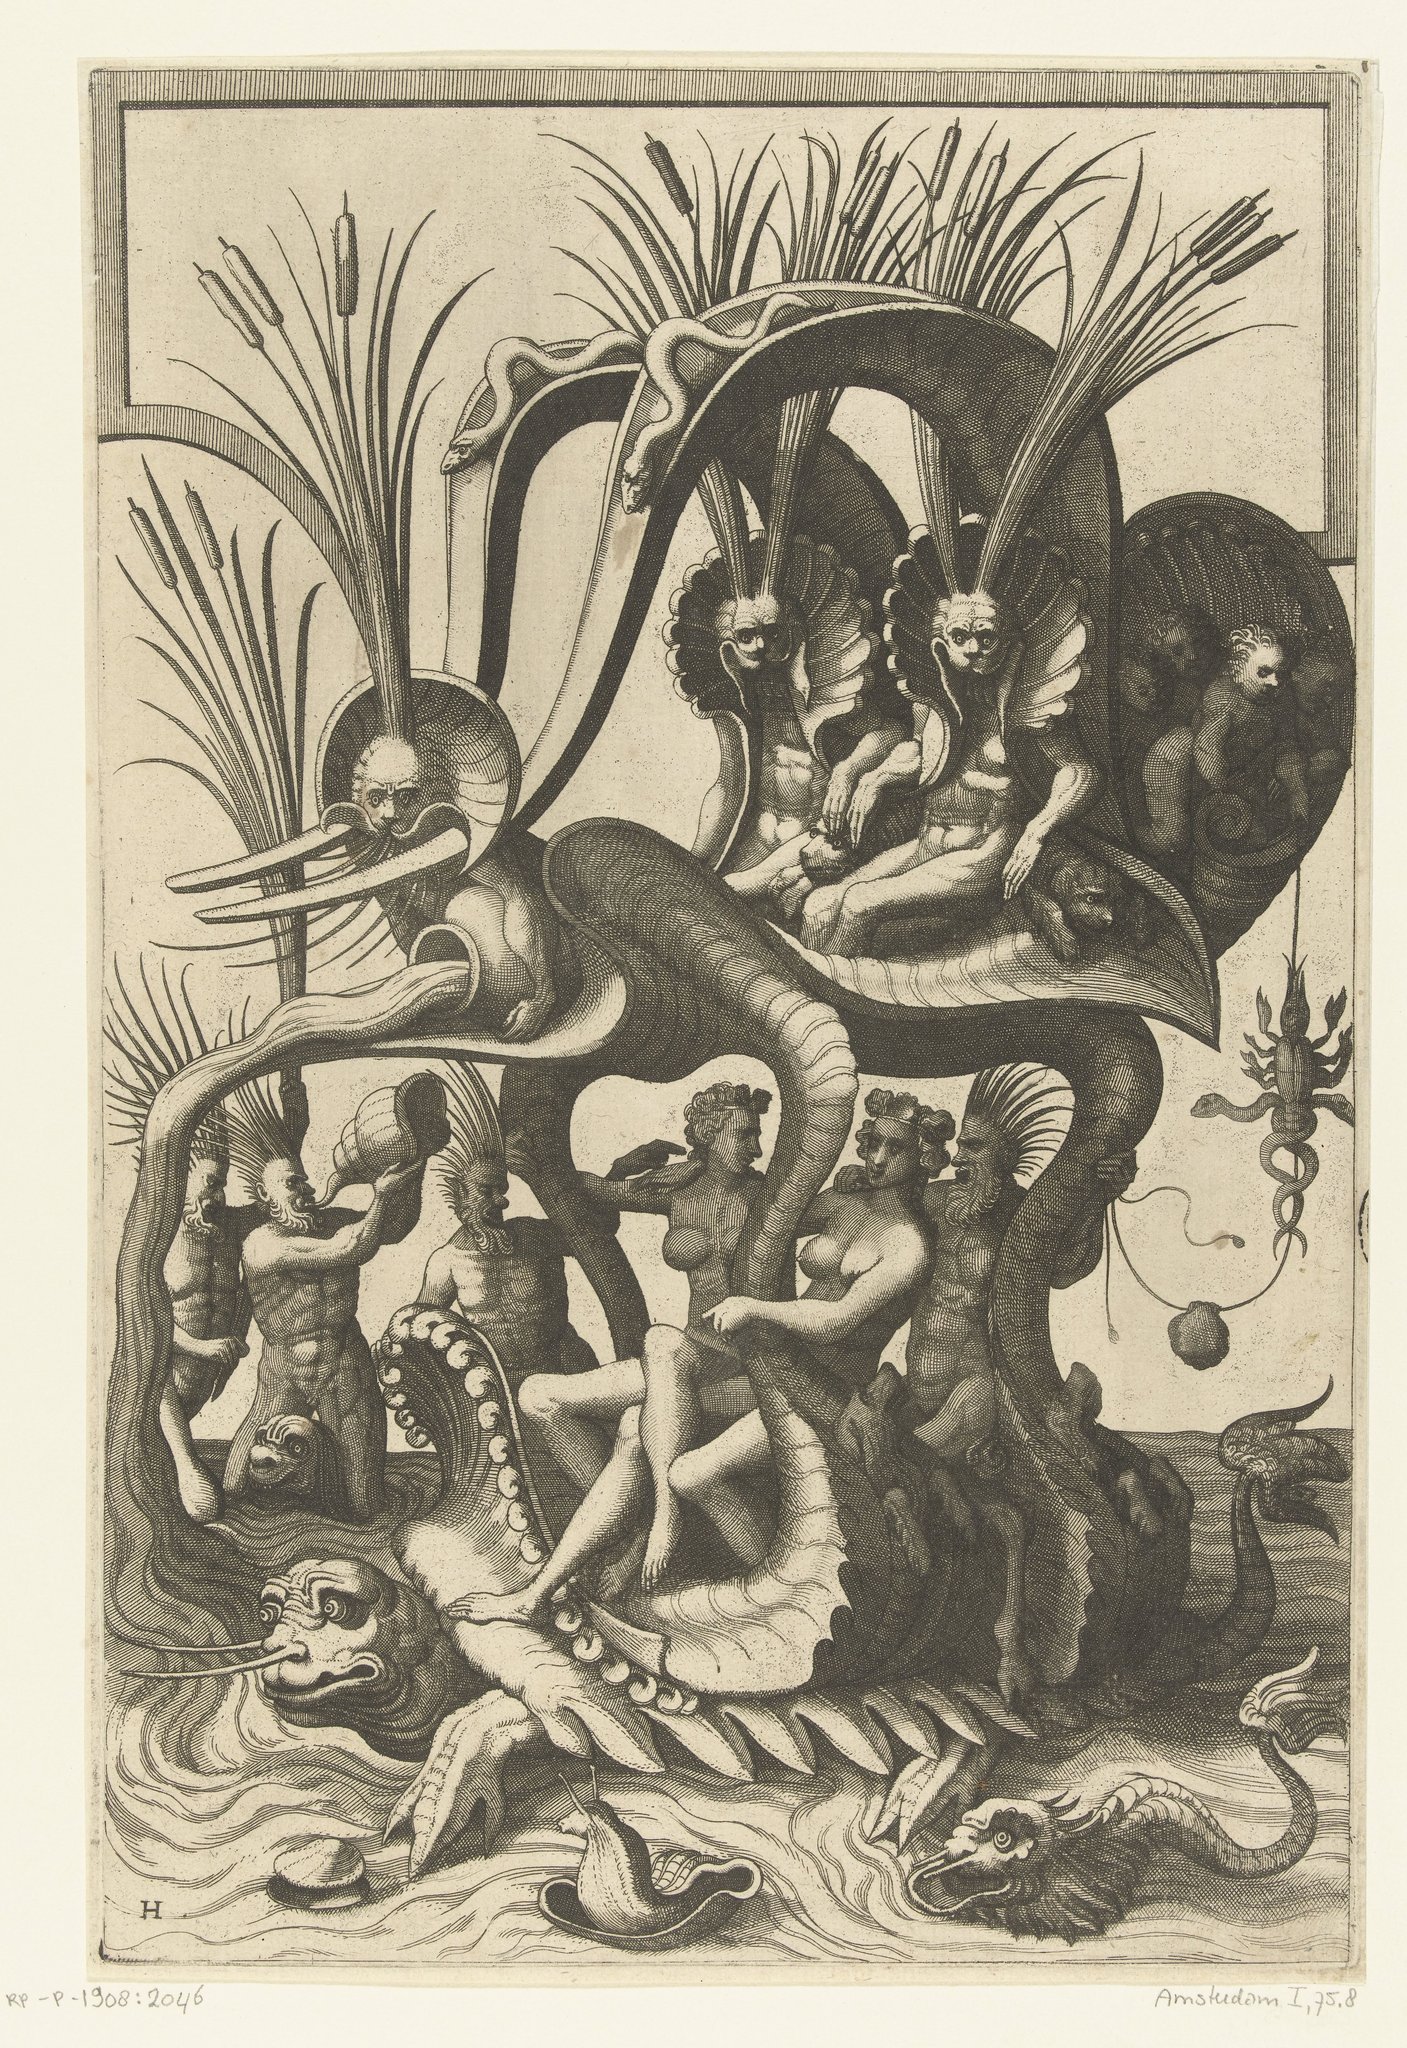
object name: ornament print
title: Veelderleij Veranderinghe van grotissen ende Compertimenten (...)Libro Primo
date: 1556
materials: paper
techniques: etching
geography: netherlands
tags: ornament ~ grotesque, tortoises, turtles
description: In de wagen zitten twee vrouwen en een sater. Boven hen zitten twee figuren met schelpvormige kragen en lisdodden op hun hoofd. Blad H uit serie van 12 bladen, genummerd A-M met vlakdecoraties van grotesken met rolwerk, saters, guirlandes, trofeeën, dieren en fantasiewezens